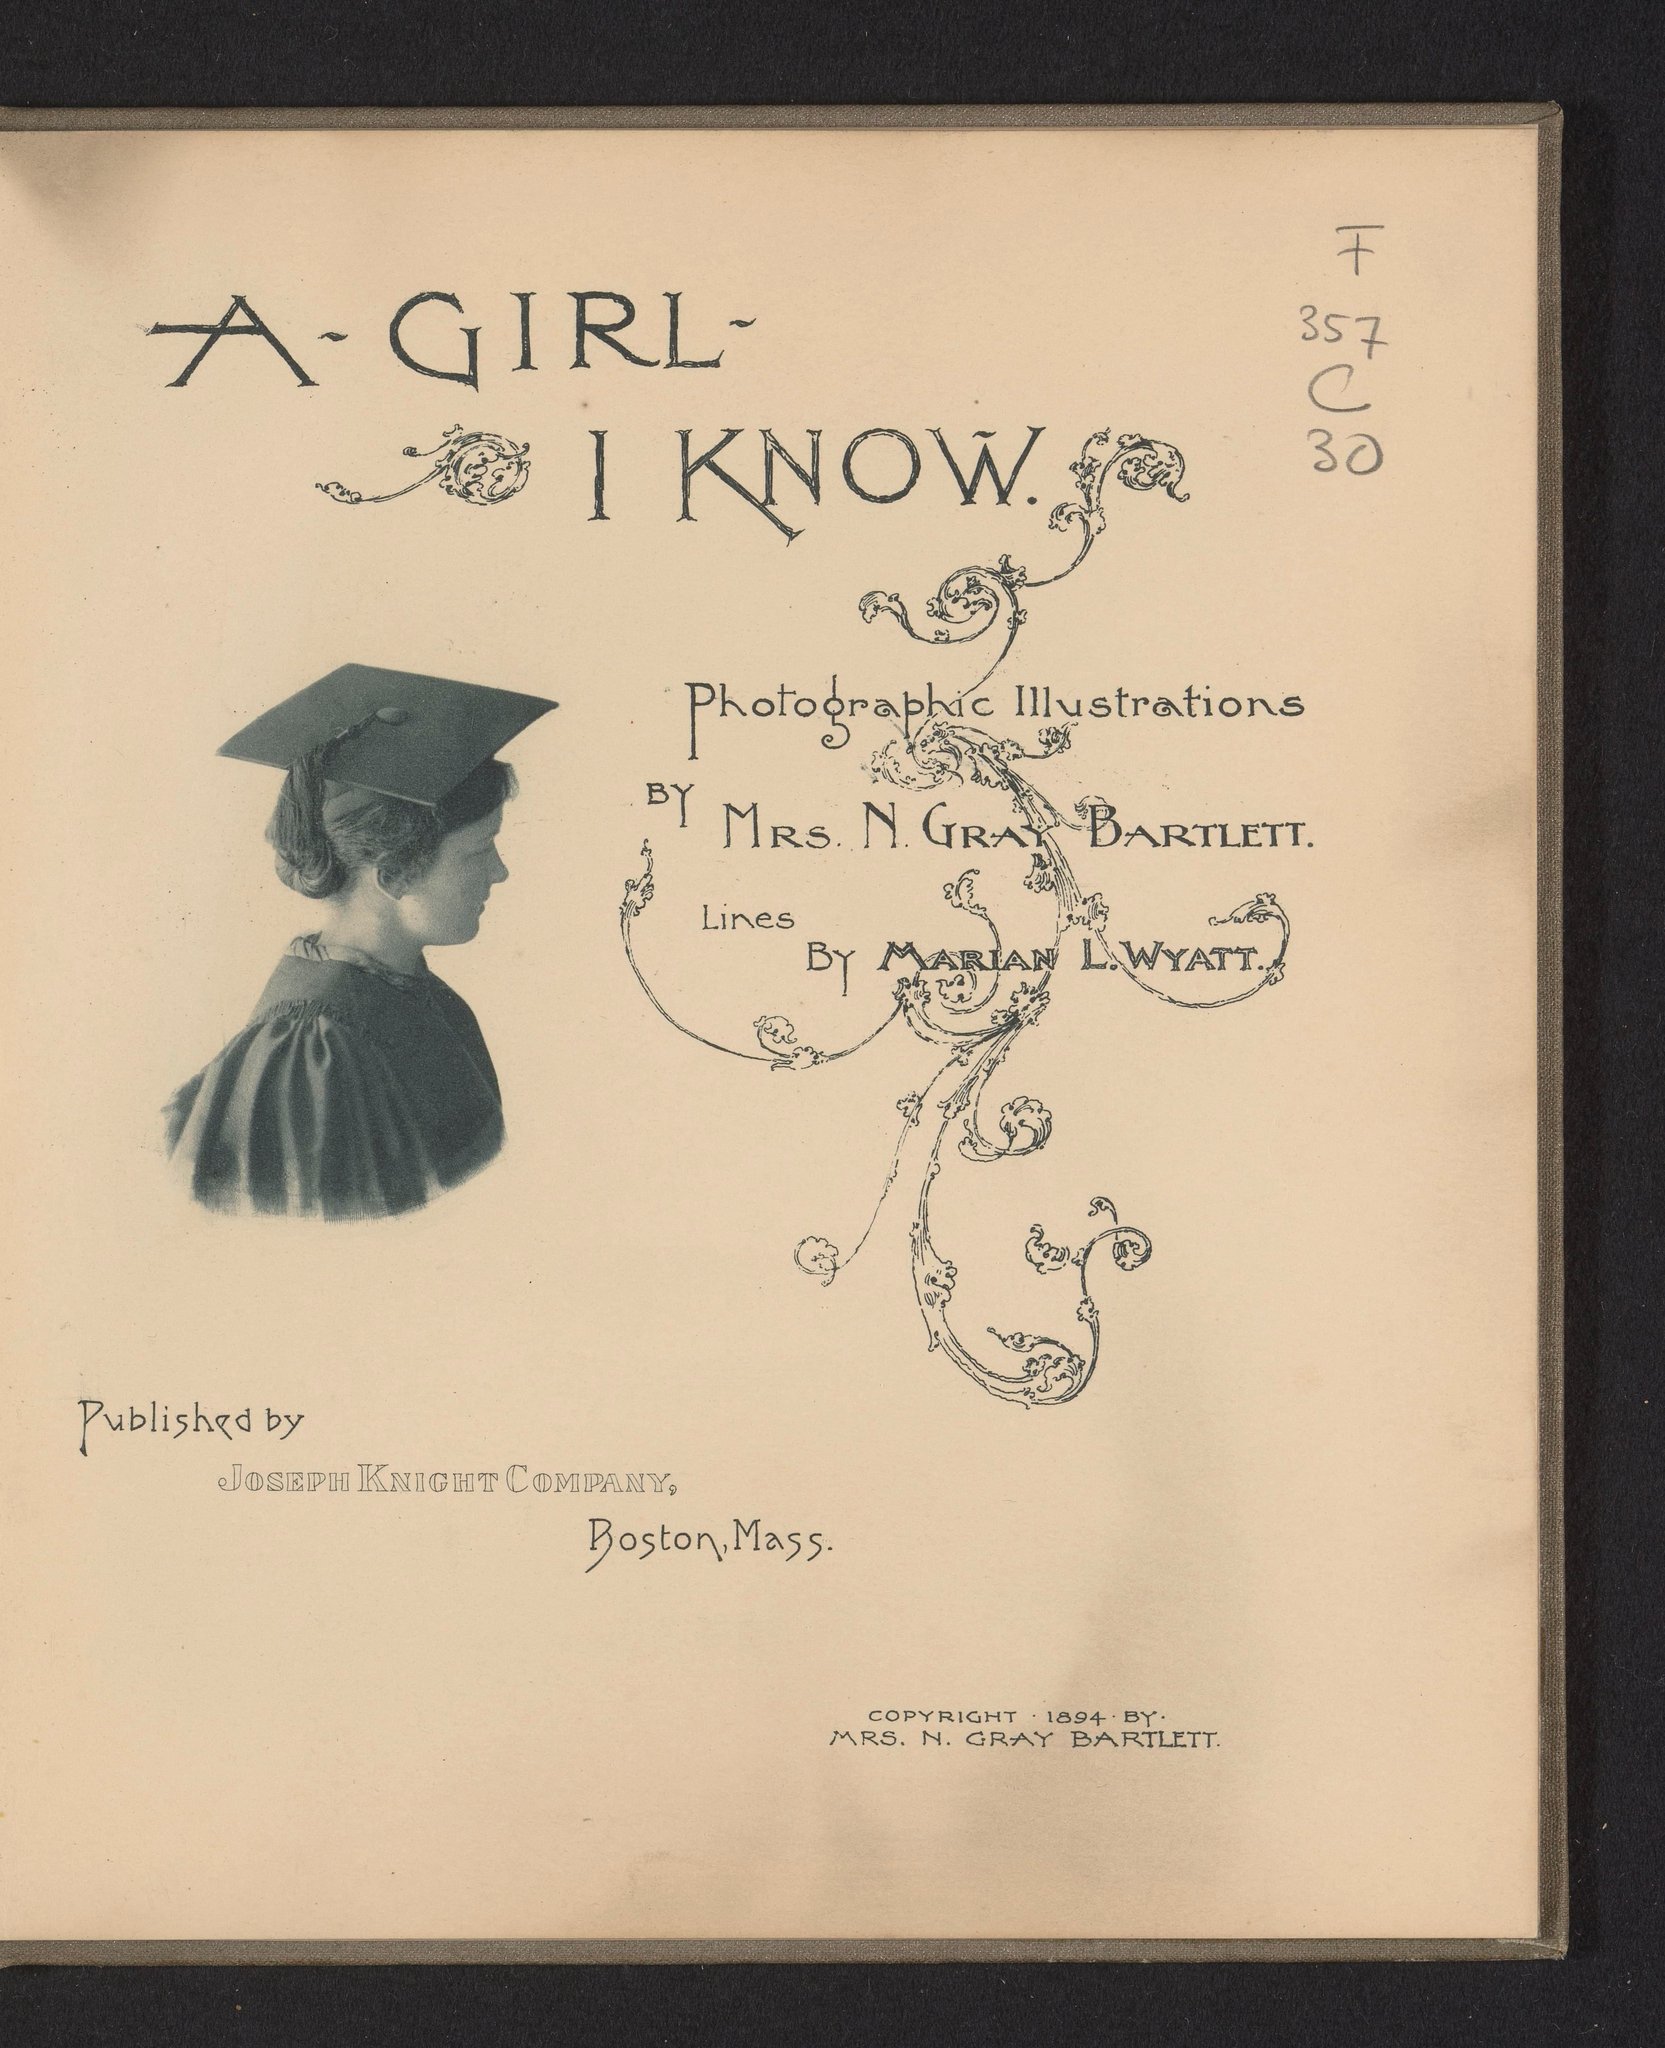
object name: page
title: Meisje met een academische baret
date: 1884-1894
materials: paper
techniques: photoaquatint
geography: united states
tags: adolescent, young woman, maiden, head-gear: beret